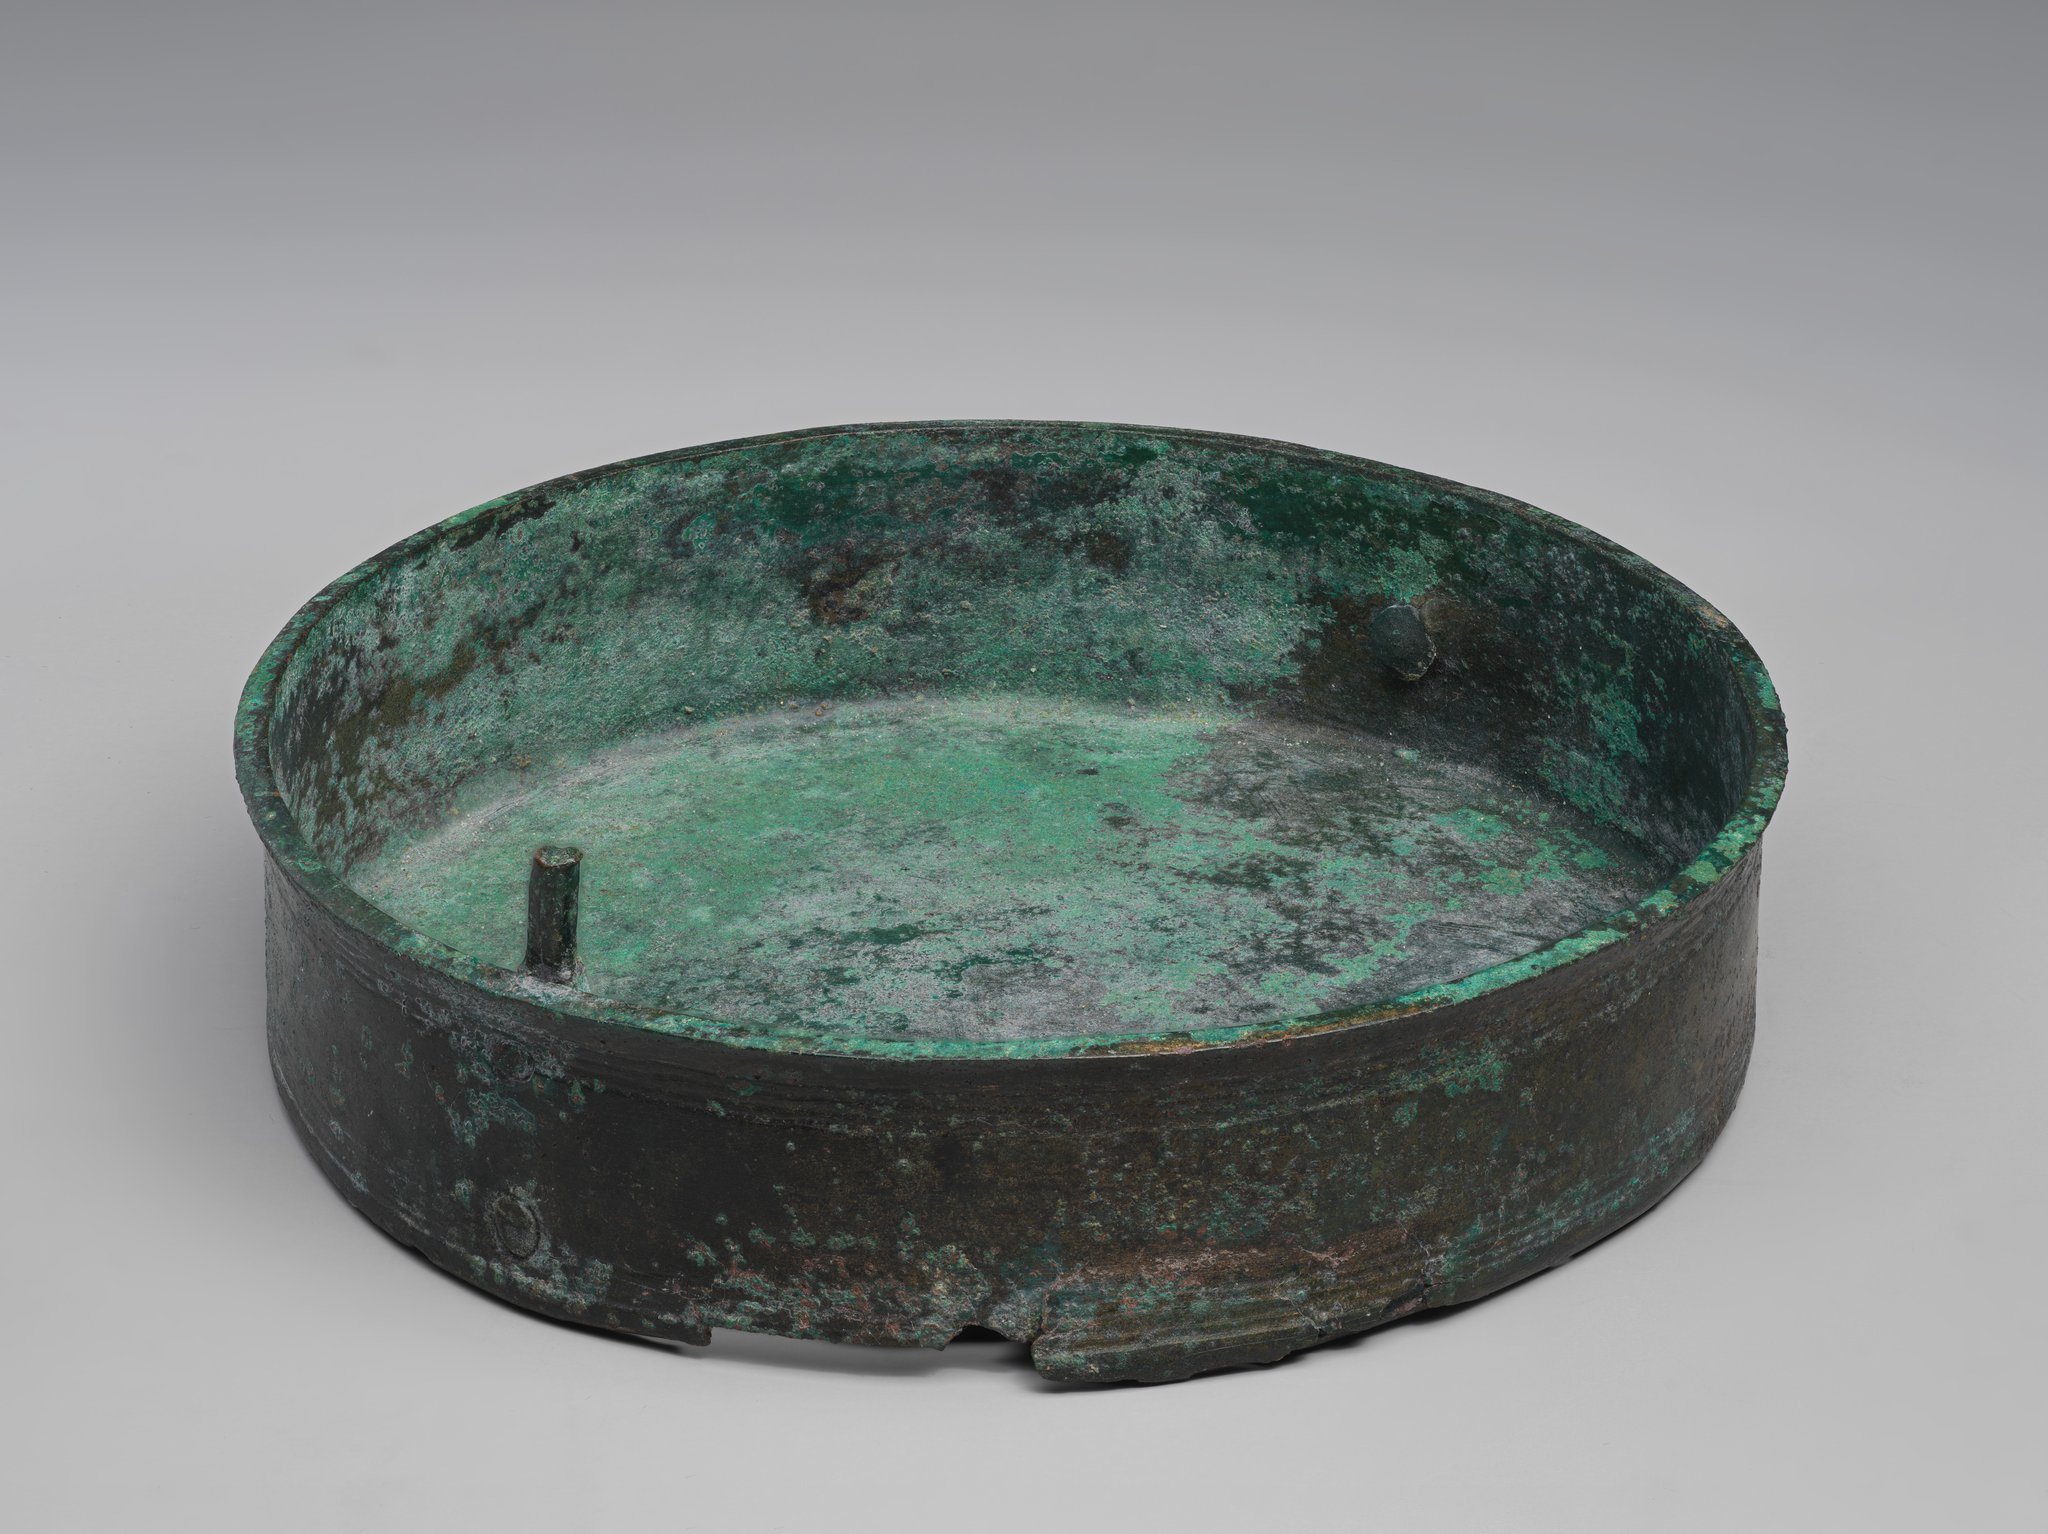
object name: pyxis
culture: iranian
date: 700-501 BCE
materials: bronze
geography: iran